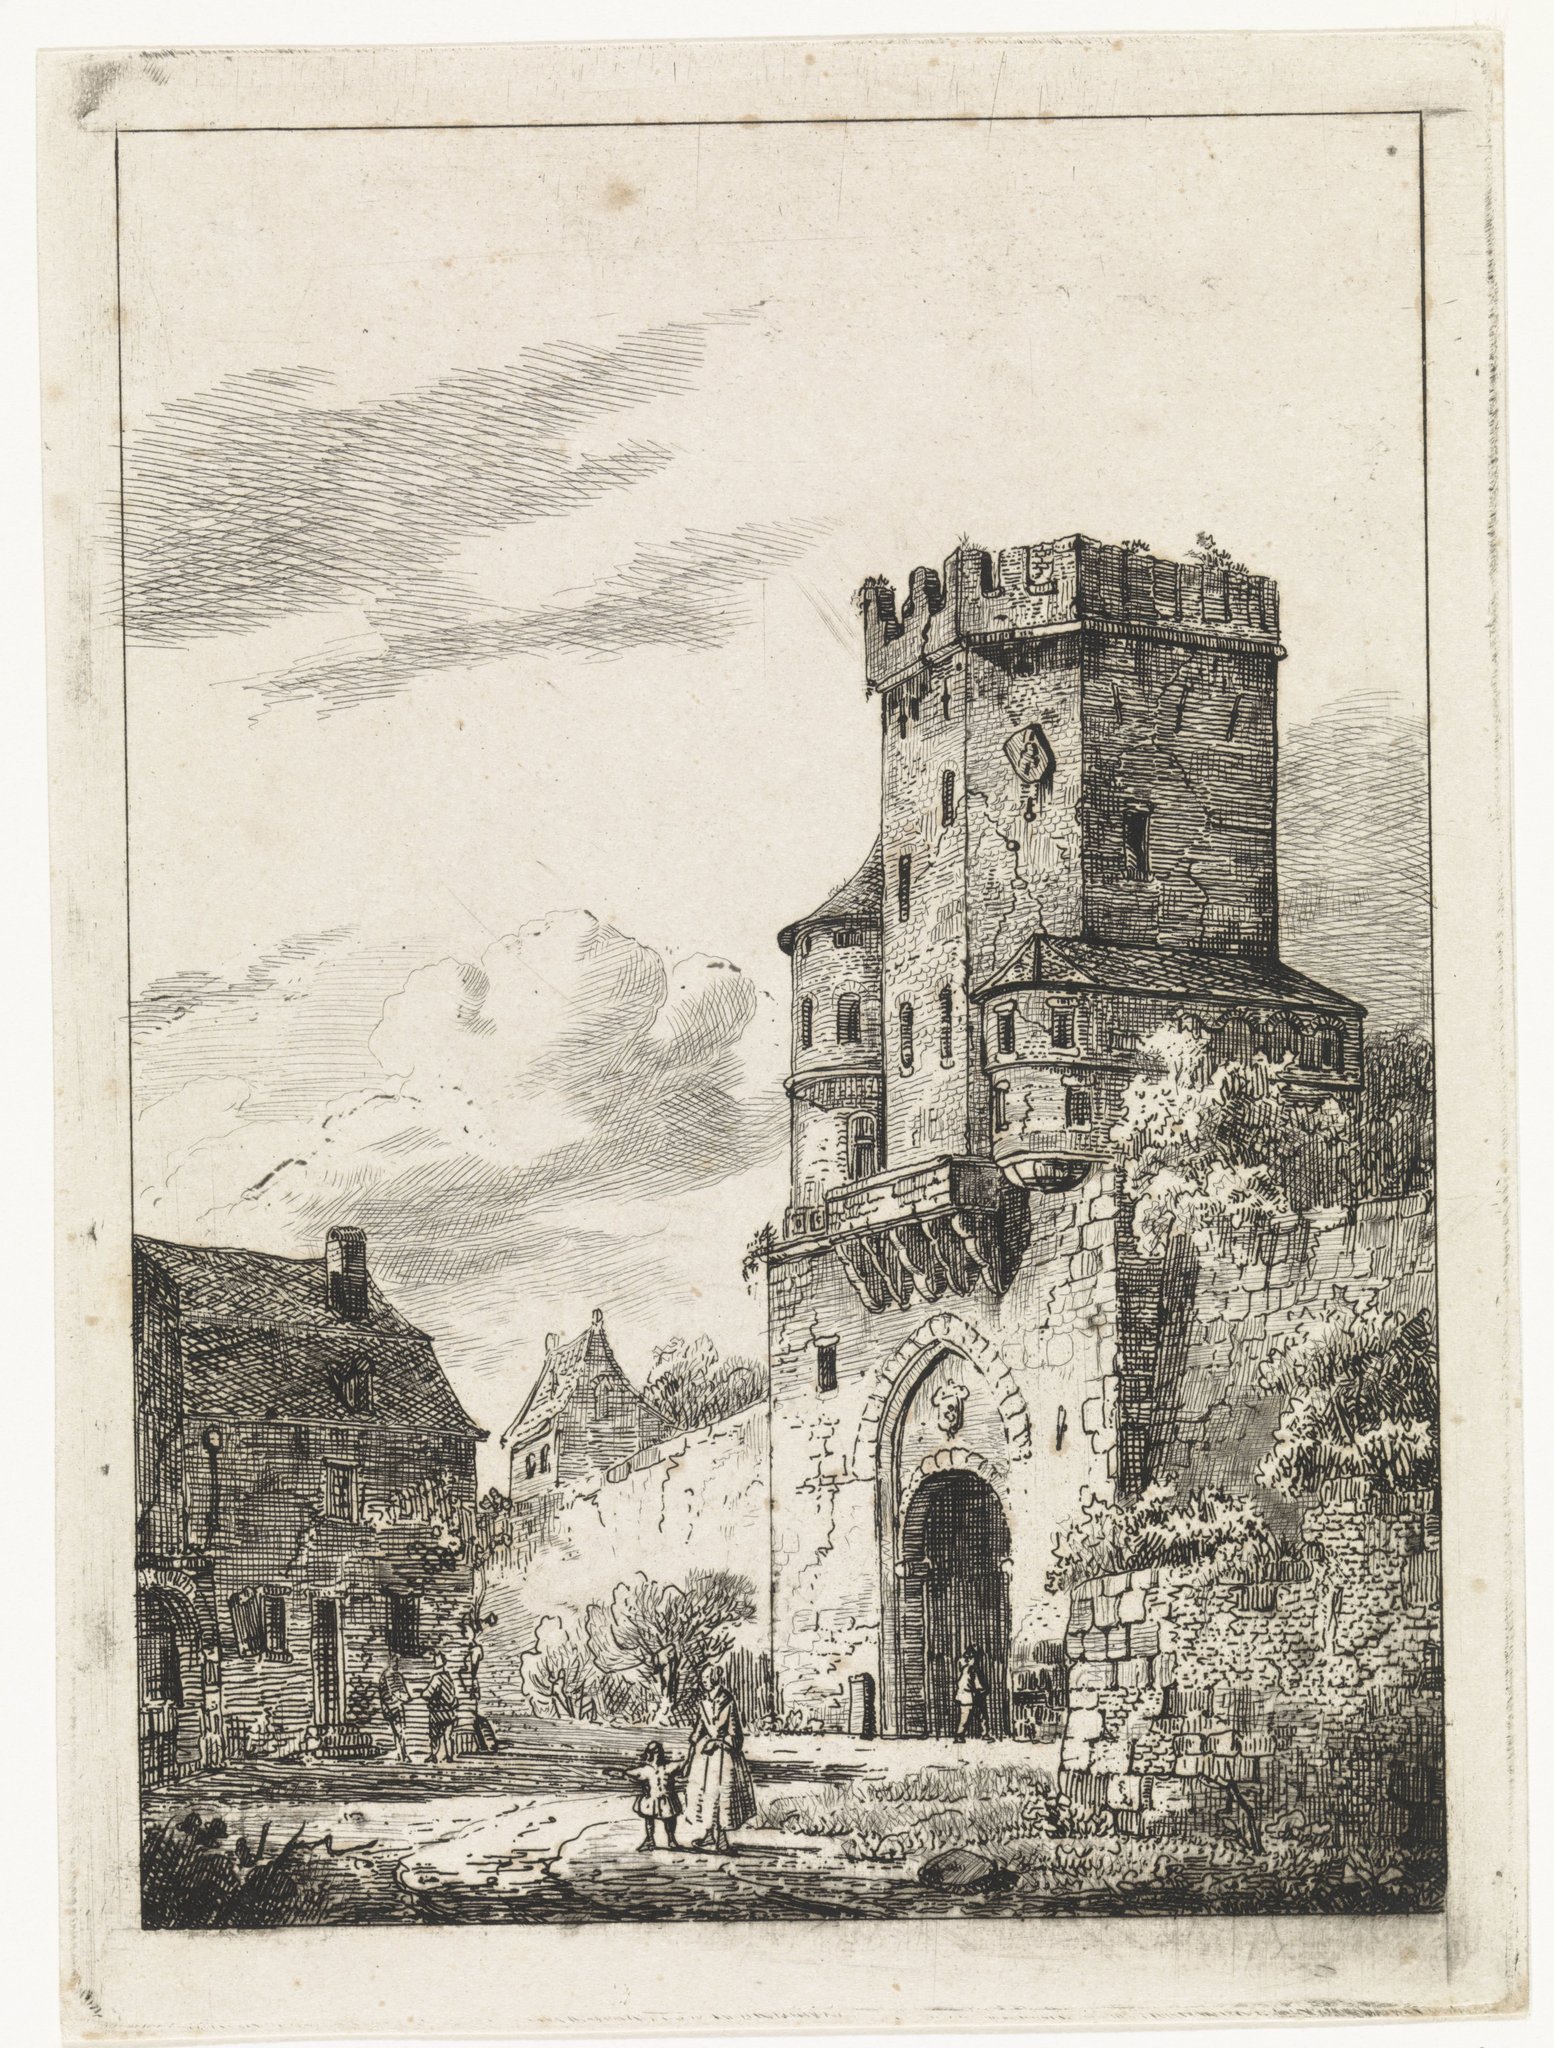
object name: print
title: Gezicht op een stadspoort met toren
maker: cornelis springer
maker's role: draughtsman, painter, print maker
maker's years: 1817-1891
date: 1843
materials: paper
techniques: etching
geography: amsterdam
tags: city-gate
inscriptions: collector's mark: Lugt 2228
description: Gezicht op een stadspoort met toren en de stadsmuren. Op de voorgrond een vrouw met een kind aan de hand.